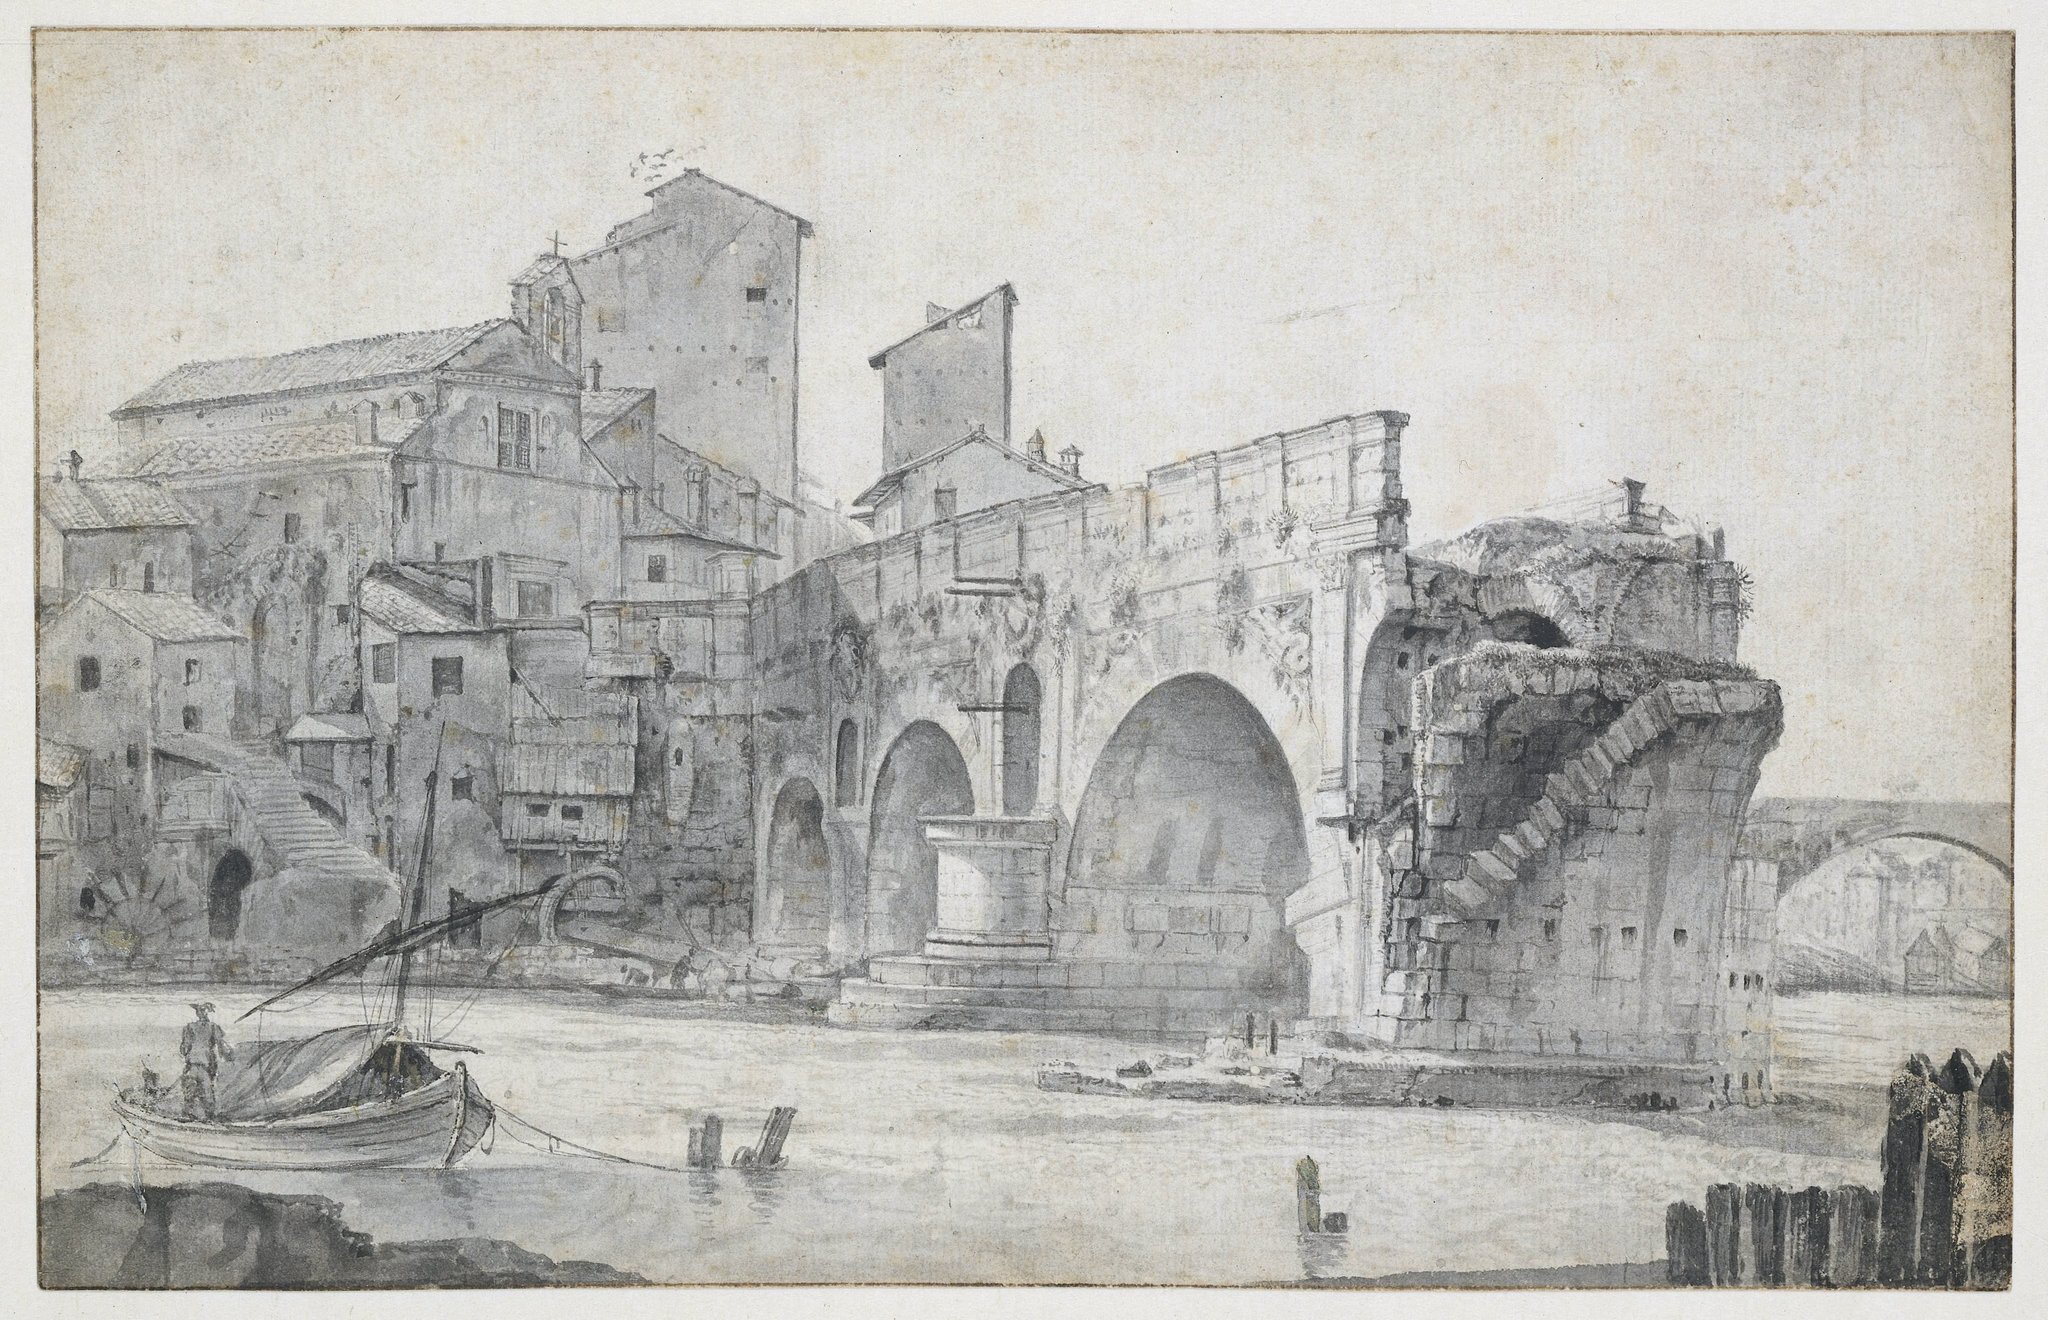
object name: drawing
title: View of the Ponte Rotto in Rome, Seen from the East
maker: jan asselijn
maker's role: draughtsman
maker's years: 1610-1652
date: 1636-1644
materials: chalk, paint, ink, paper, watercolor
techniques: brush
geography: rome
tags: city-view in general; 'veduta', bridge in city across river, canal, etc.